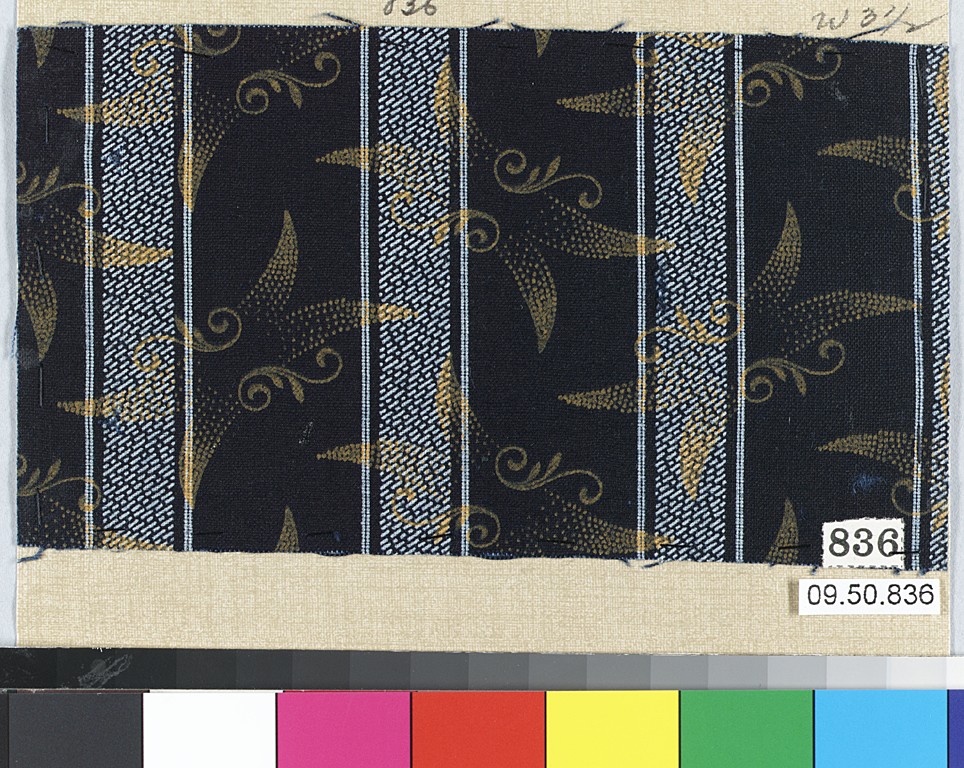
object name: piece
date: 1801-1900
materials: cotton